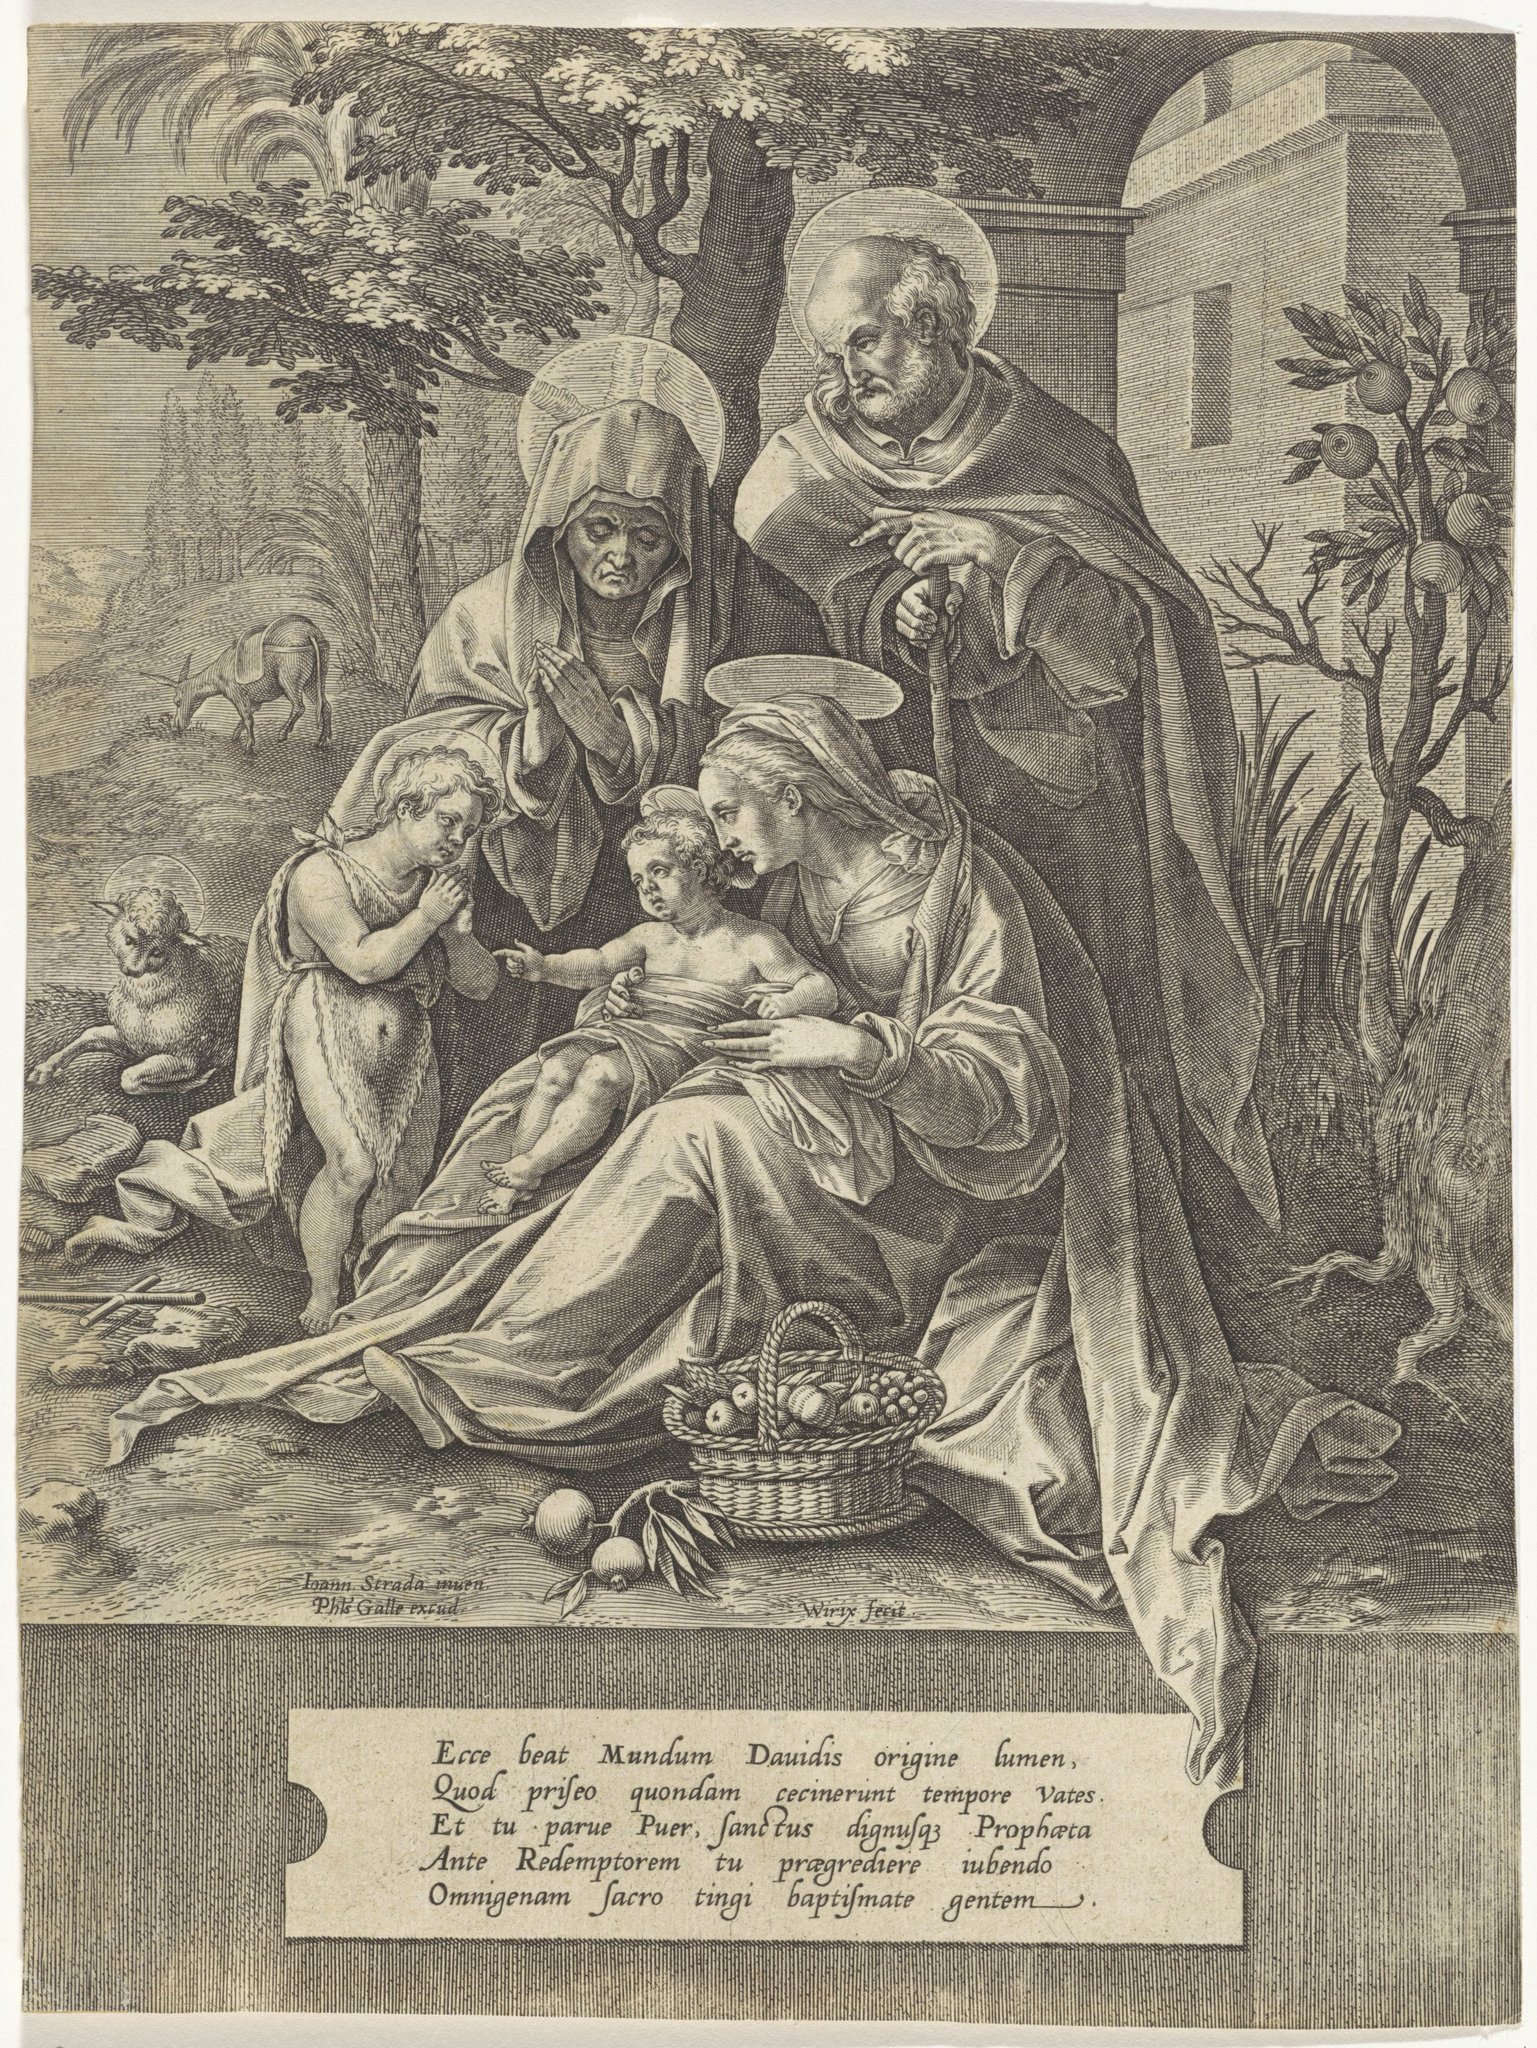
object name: print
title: Heilige Familie met Elisabet en Johannes de Doper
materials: paper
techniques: engraving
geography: antwerp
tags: ass, donkey, fruit, holy family with john the baptist, elisabeth present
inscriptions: collector's mark: Lugt 2228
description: Maria zit met het Christuskind op schoot op de grond, naast een mand met fruit. Voor hen knielen de jonge Johannes de Doper en diens moeder Elisabet. Achter hen staat Jozef. Links op de achtergrond graast een ezel. In het kader onder de voorstelling een vijfregelig onderschrift in het Latijn.